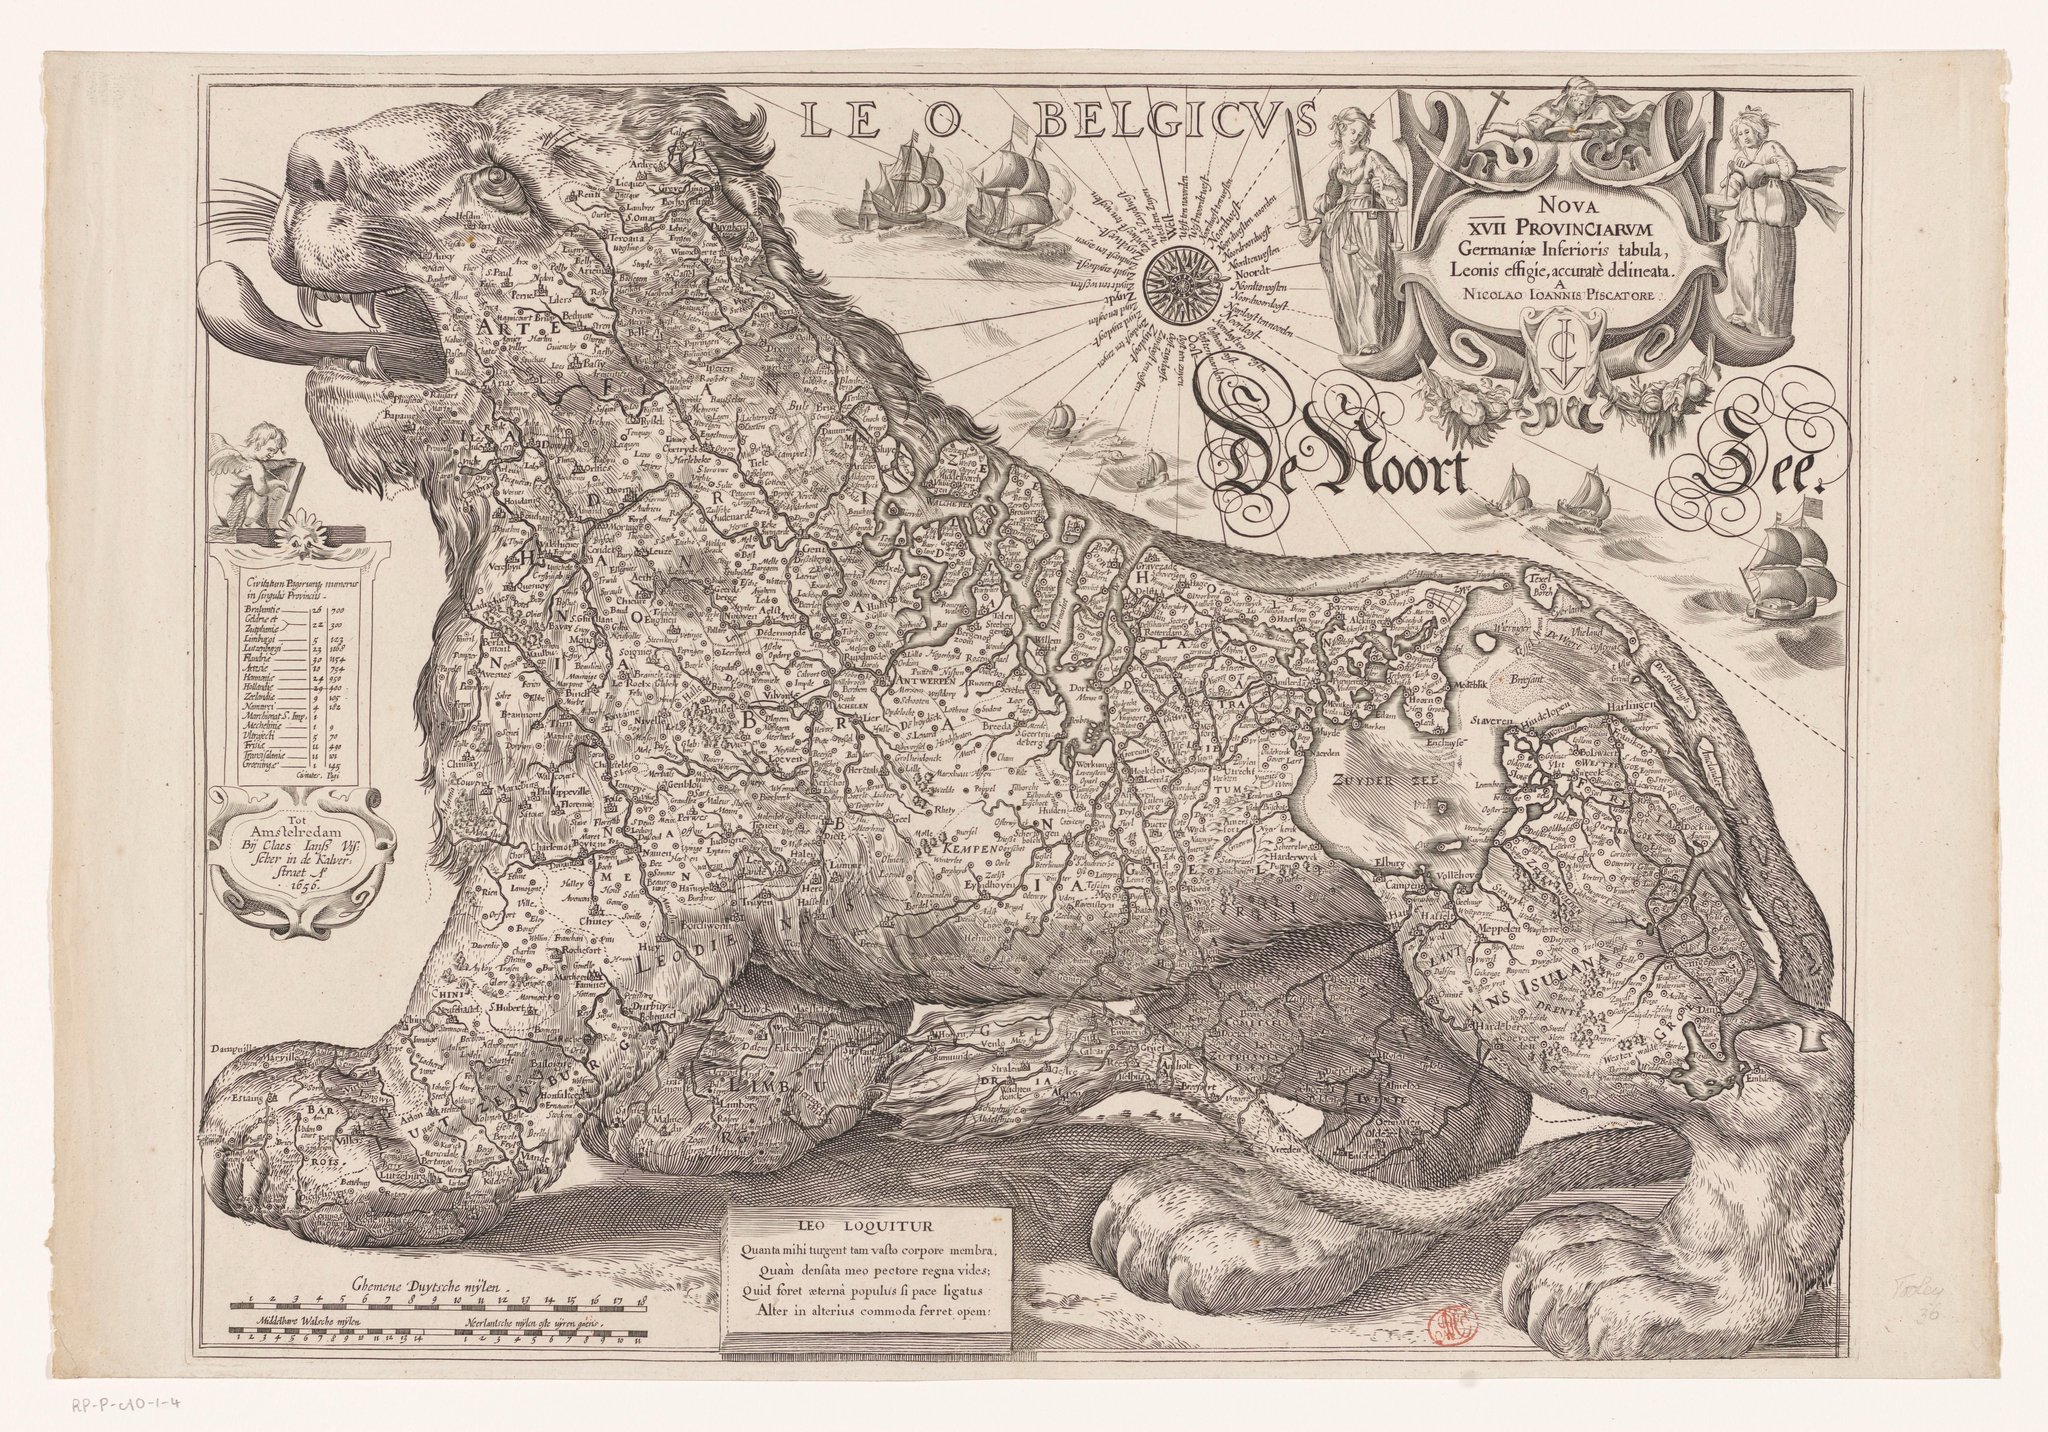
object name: print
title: Map of the Seventeen Netherlandish Provinces in the Shape of the Belgic Lion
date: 1656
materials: paper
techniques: engraving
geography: amsterdam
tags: temperance, 'temperantia'; 'temperanza' (ripa) ~ one of the four cardinal virtues, justice, 'justitia'; 'giustitia divina' (ripa) ~ one of the four cardinal virtues, faith, 'fides'; 'fede', 'fede catholica', 'fede christiana', 'fede christiana catholica' (ripa) ~ one of the three theological virtues, maps of separate countries or regions, beasts of prey, predatory animals: lion, low countries, belgium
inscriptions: collector's mark: Lugt 2228, collector's mark: Lugt 195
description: The map of the Netherlands is here depicted in the shape of the Leo Belgicus (the Belgic Lion). During the Eighty Years’ War (1568-1648) it was a powerful symbol of the desired unity of the Netherlandish provinces. Many maps of this kind appeared in that period and remained popular even after the Revolt. This one was issued at least five times between 1609 and 1656.